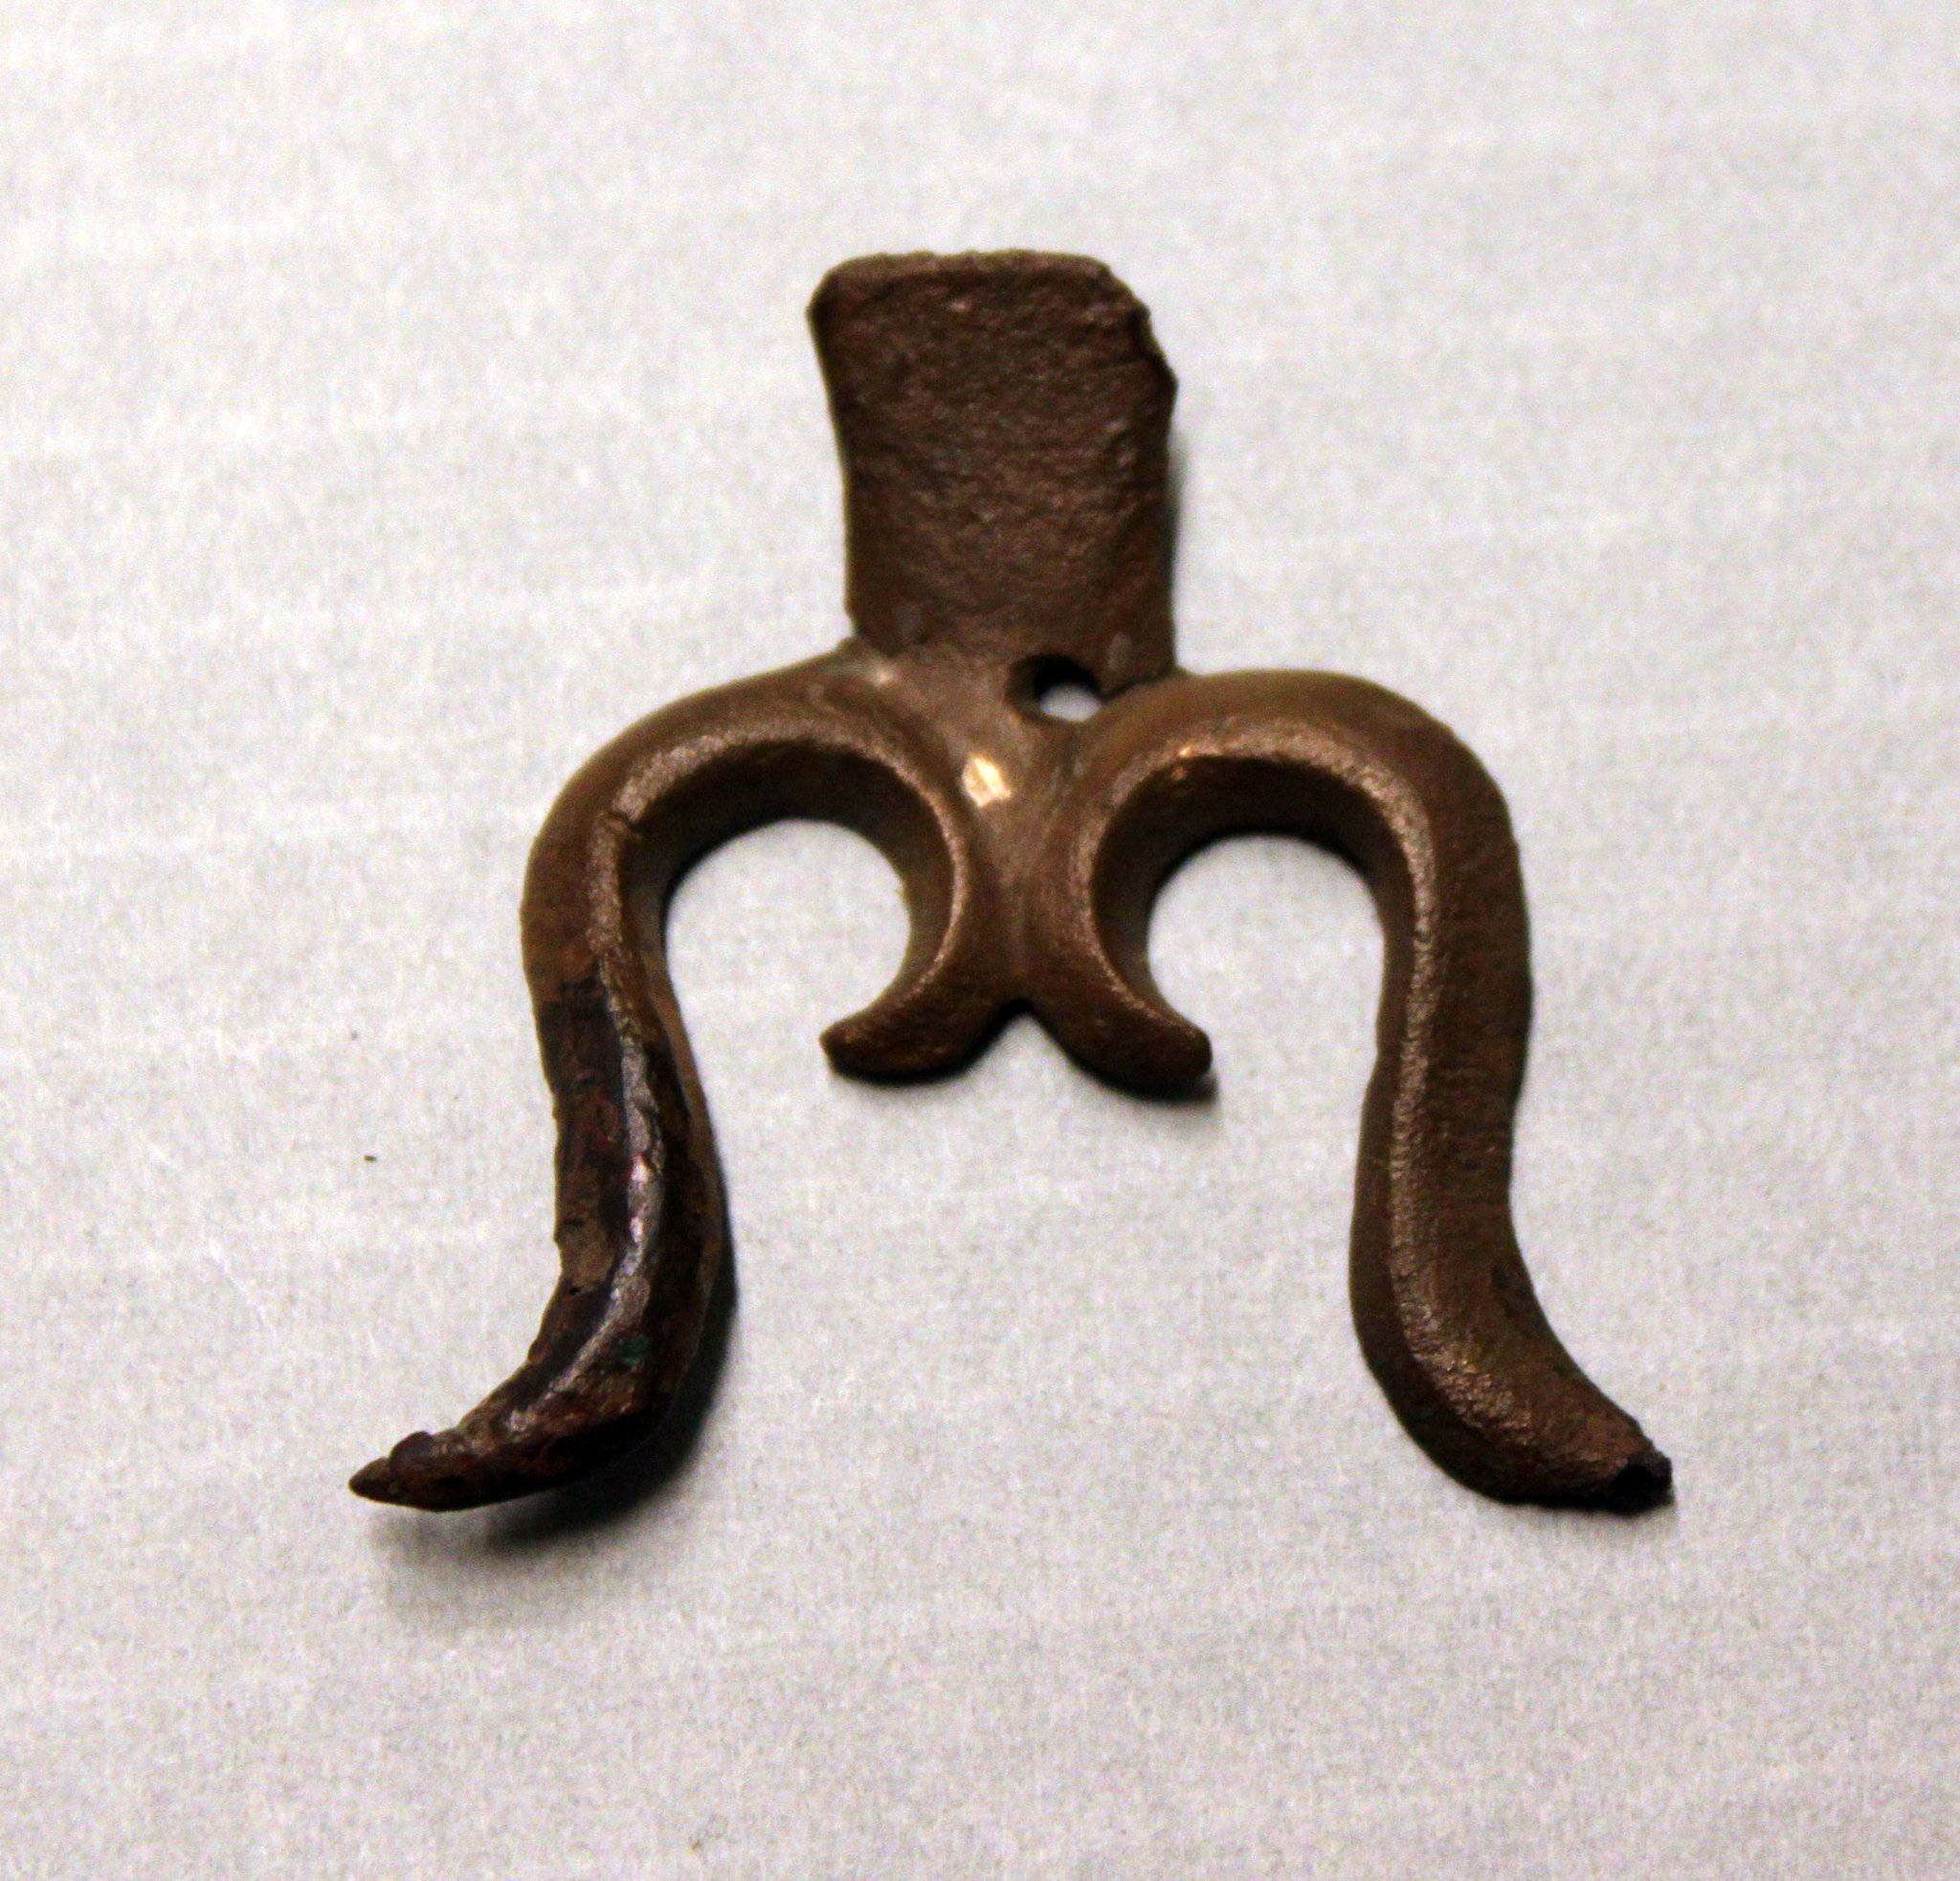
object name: horse harness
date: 901-1100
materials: bronze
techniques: casting, silvered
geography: iran